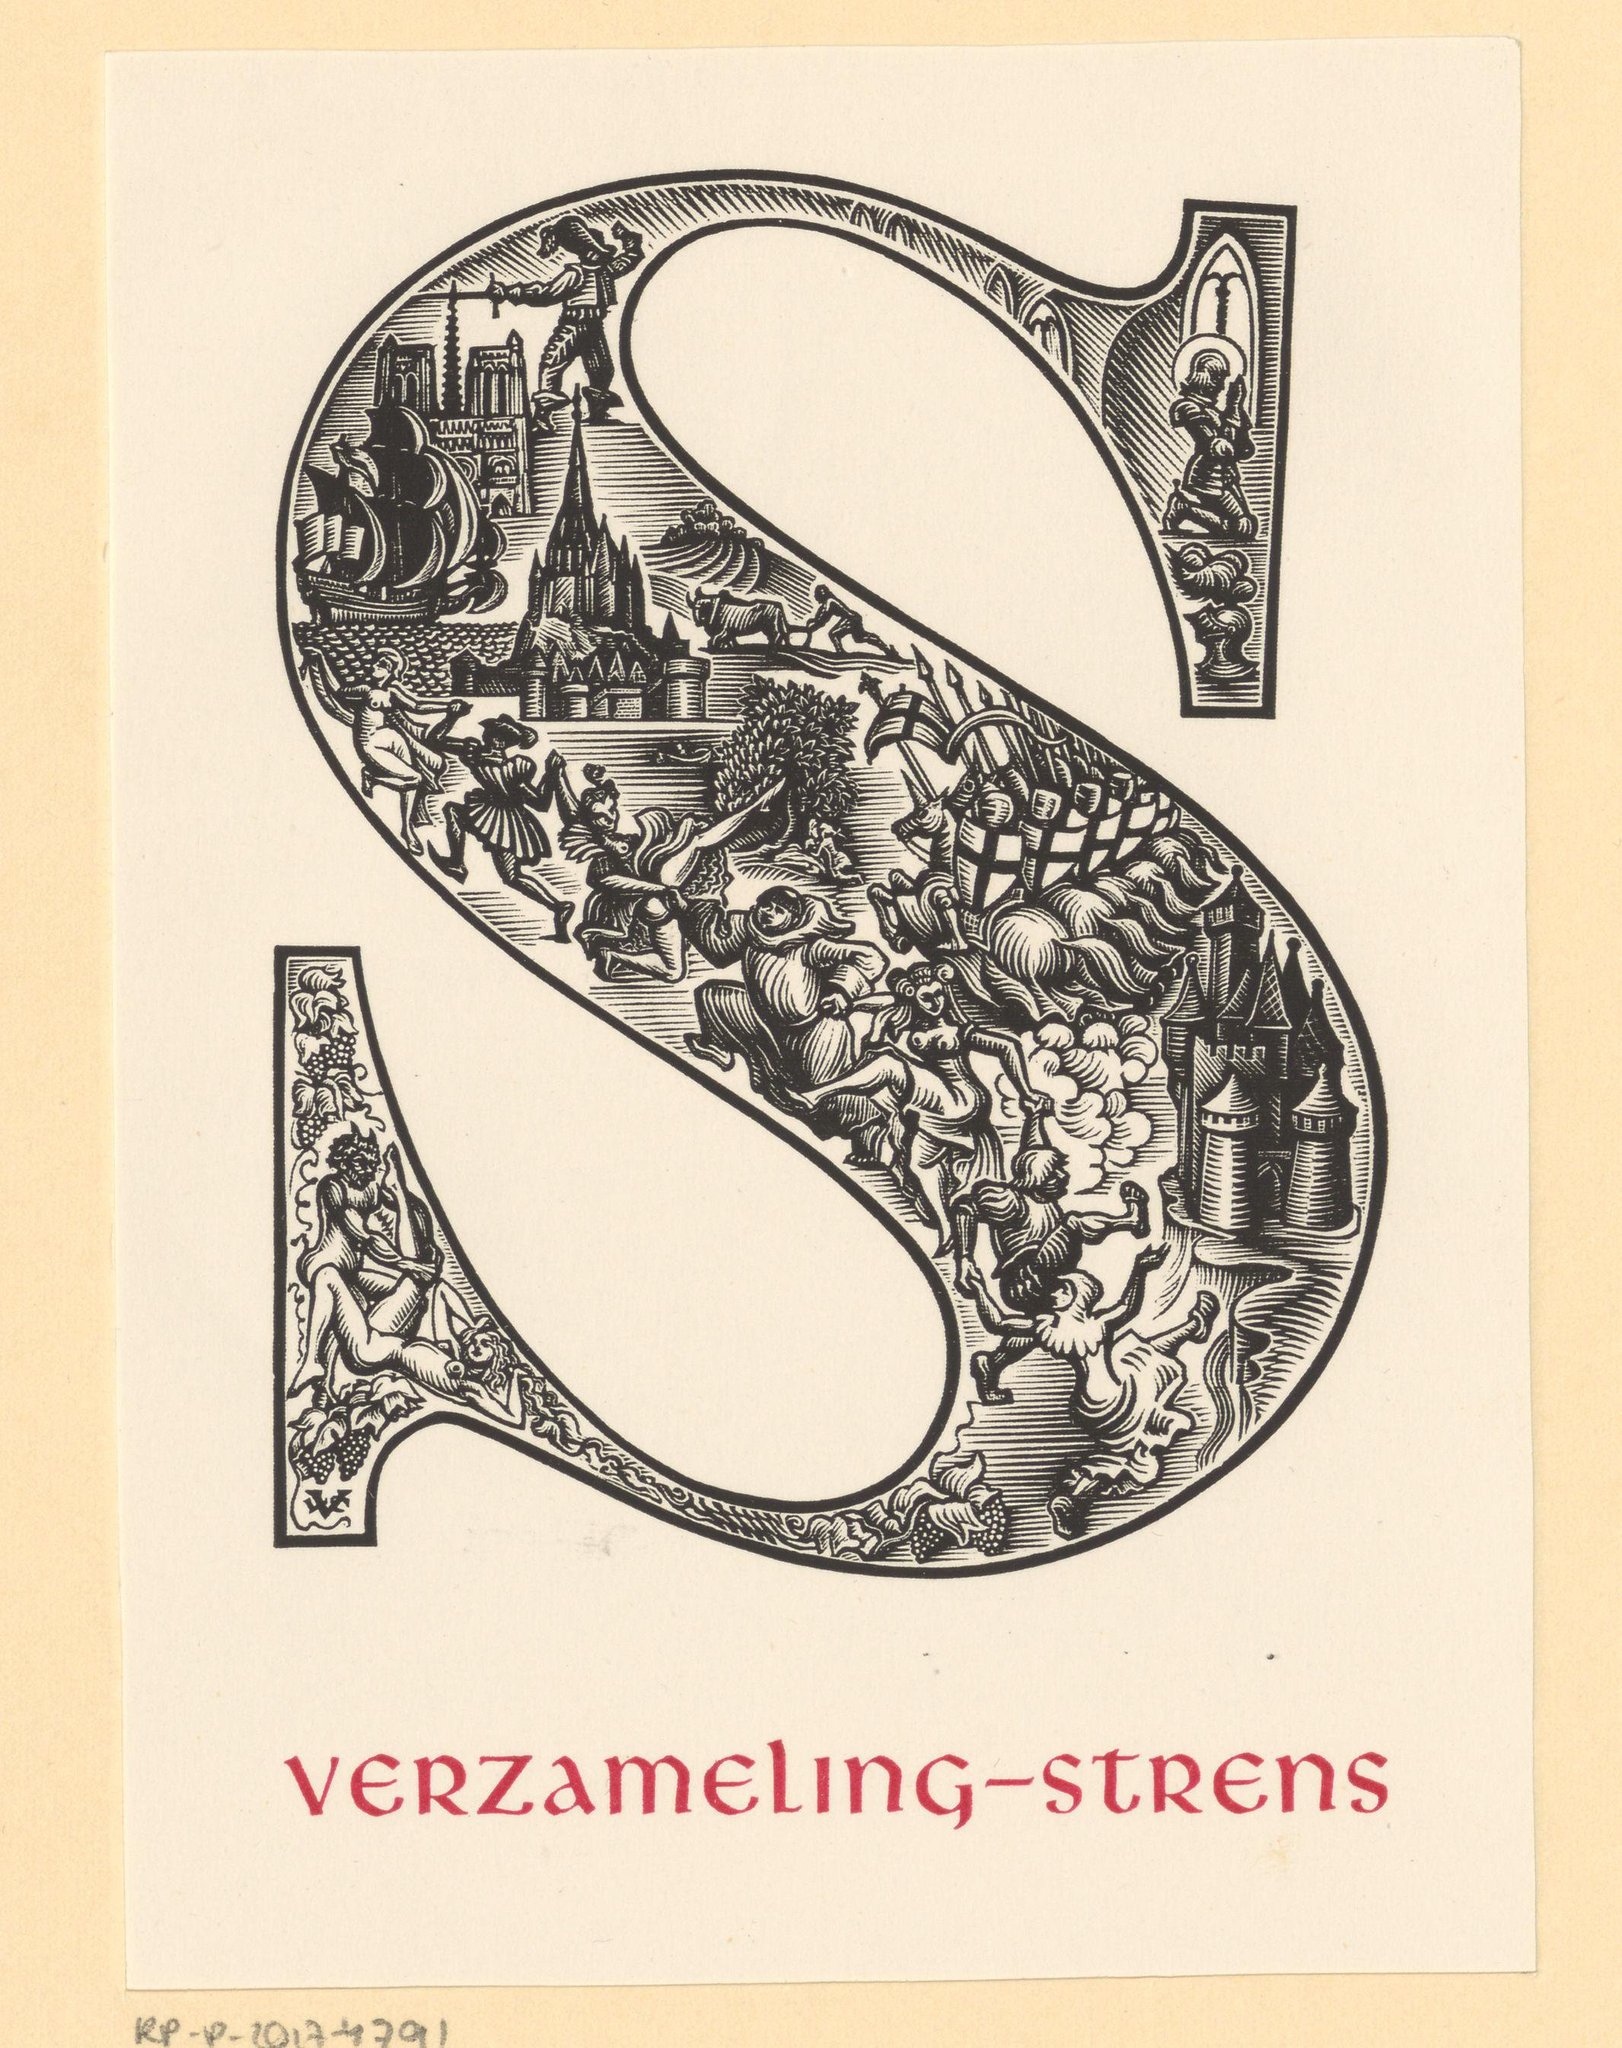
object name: bookplate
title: Ex libris van de Verzameling Strens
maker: valentin le campion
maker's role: print maker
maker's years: 1861-1952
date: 1938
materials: paper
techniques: engraving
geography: paris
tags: eugène louis charles marie strens, sailing-ship, sailing-boat, castle, satyrs, fauns, sileni, medieval history, middle ages (historical epoch), woman (showing herself) undressed, quasi-nude, group dancing, knight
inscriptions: inscription: ‘Valentin le Campion, hgr. 1938 / Tent. Konstfackskolan 1951-nr. 165. [Str. 461c]’, workshop stamp: ‘Valentin le Campion’